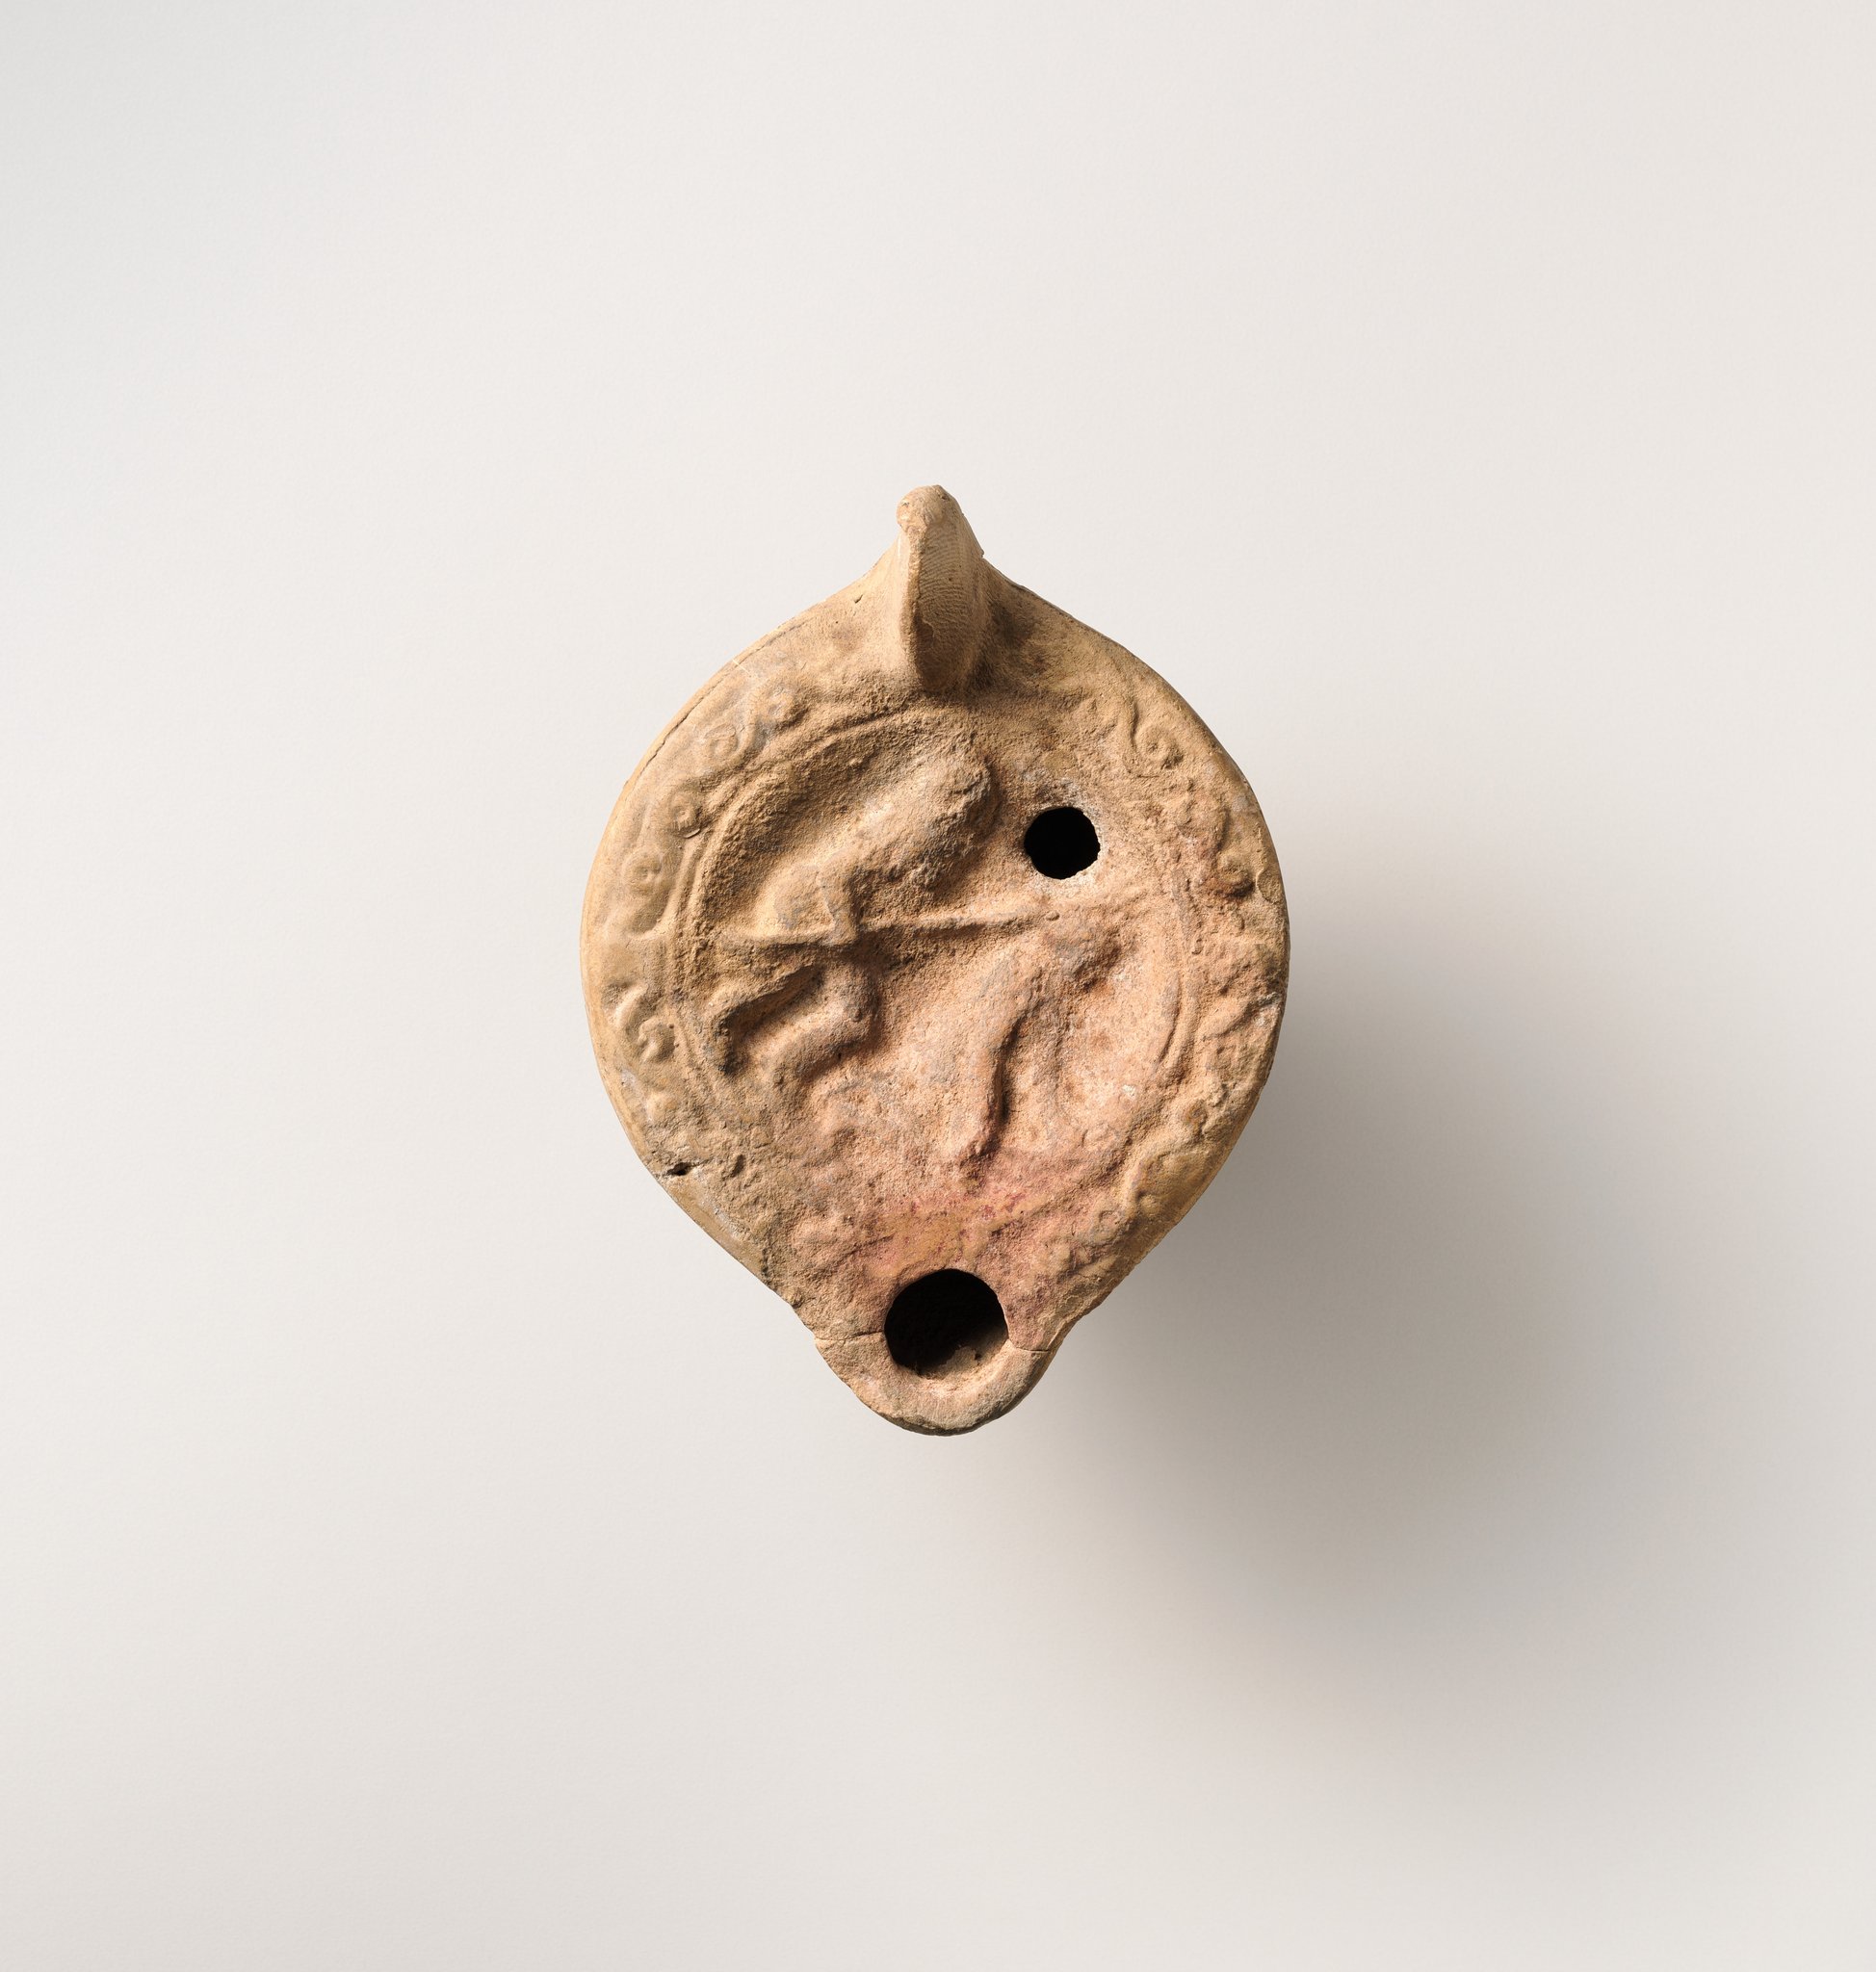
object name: lamp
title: Terracotta oil lamp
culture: roman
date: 101-200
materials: terracotta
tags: gladiators